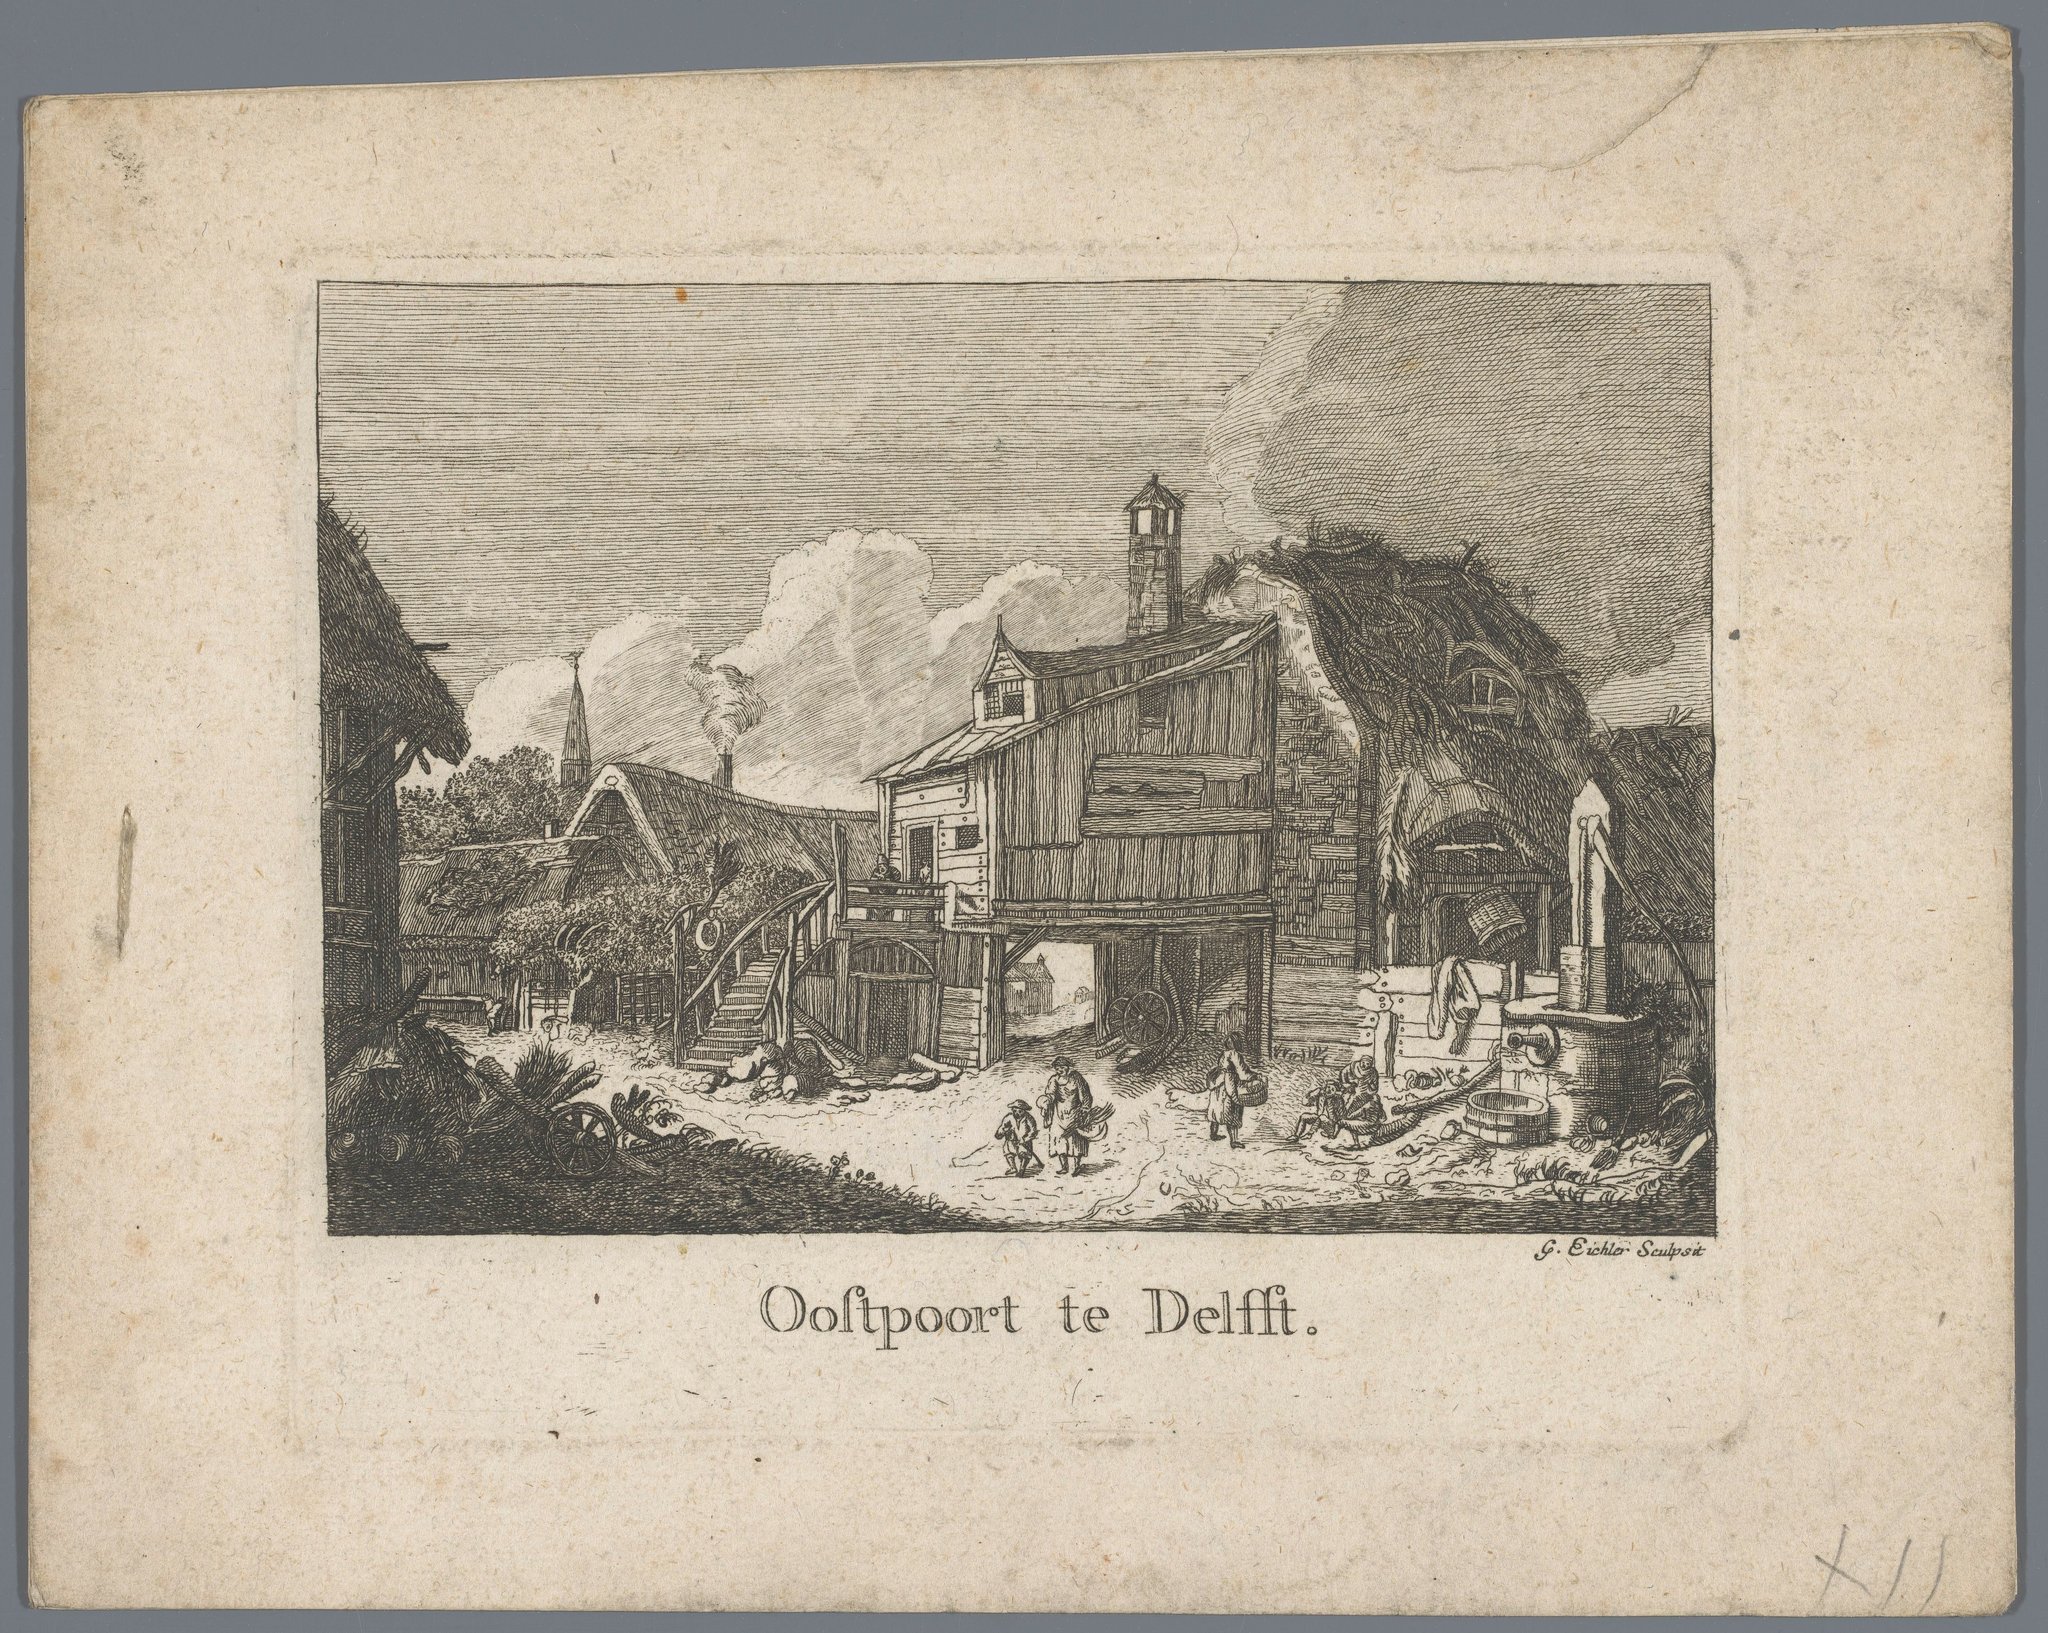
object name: print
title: Oostpoort te Delft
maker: gottfried eichler (ii)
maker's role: draughtsman, print maker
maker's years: 1715-1770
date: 1725-1770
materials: paper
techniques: etching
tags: city-view in general; 'veduta'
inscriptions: collector's mark: Lugt 2760, collector's mark: Lugt 2228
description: Deze prent is met draad gebonden aan drie soortgelijke stadsgezichten van Gottfried Eichler.